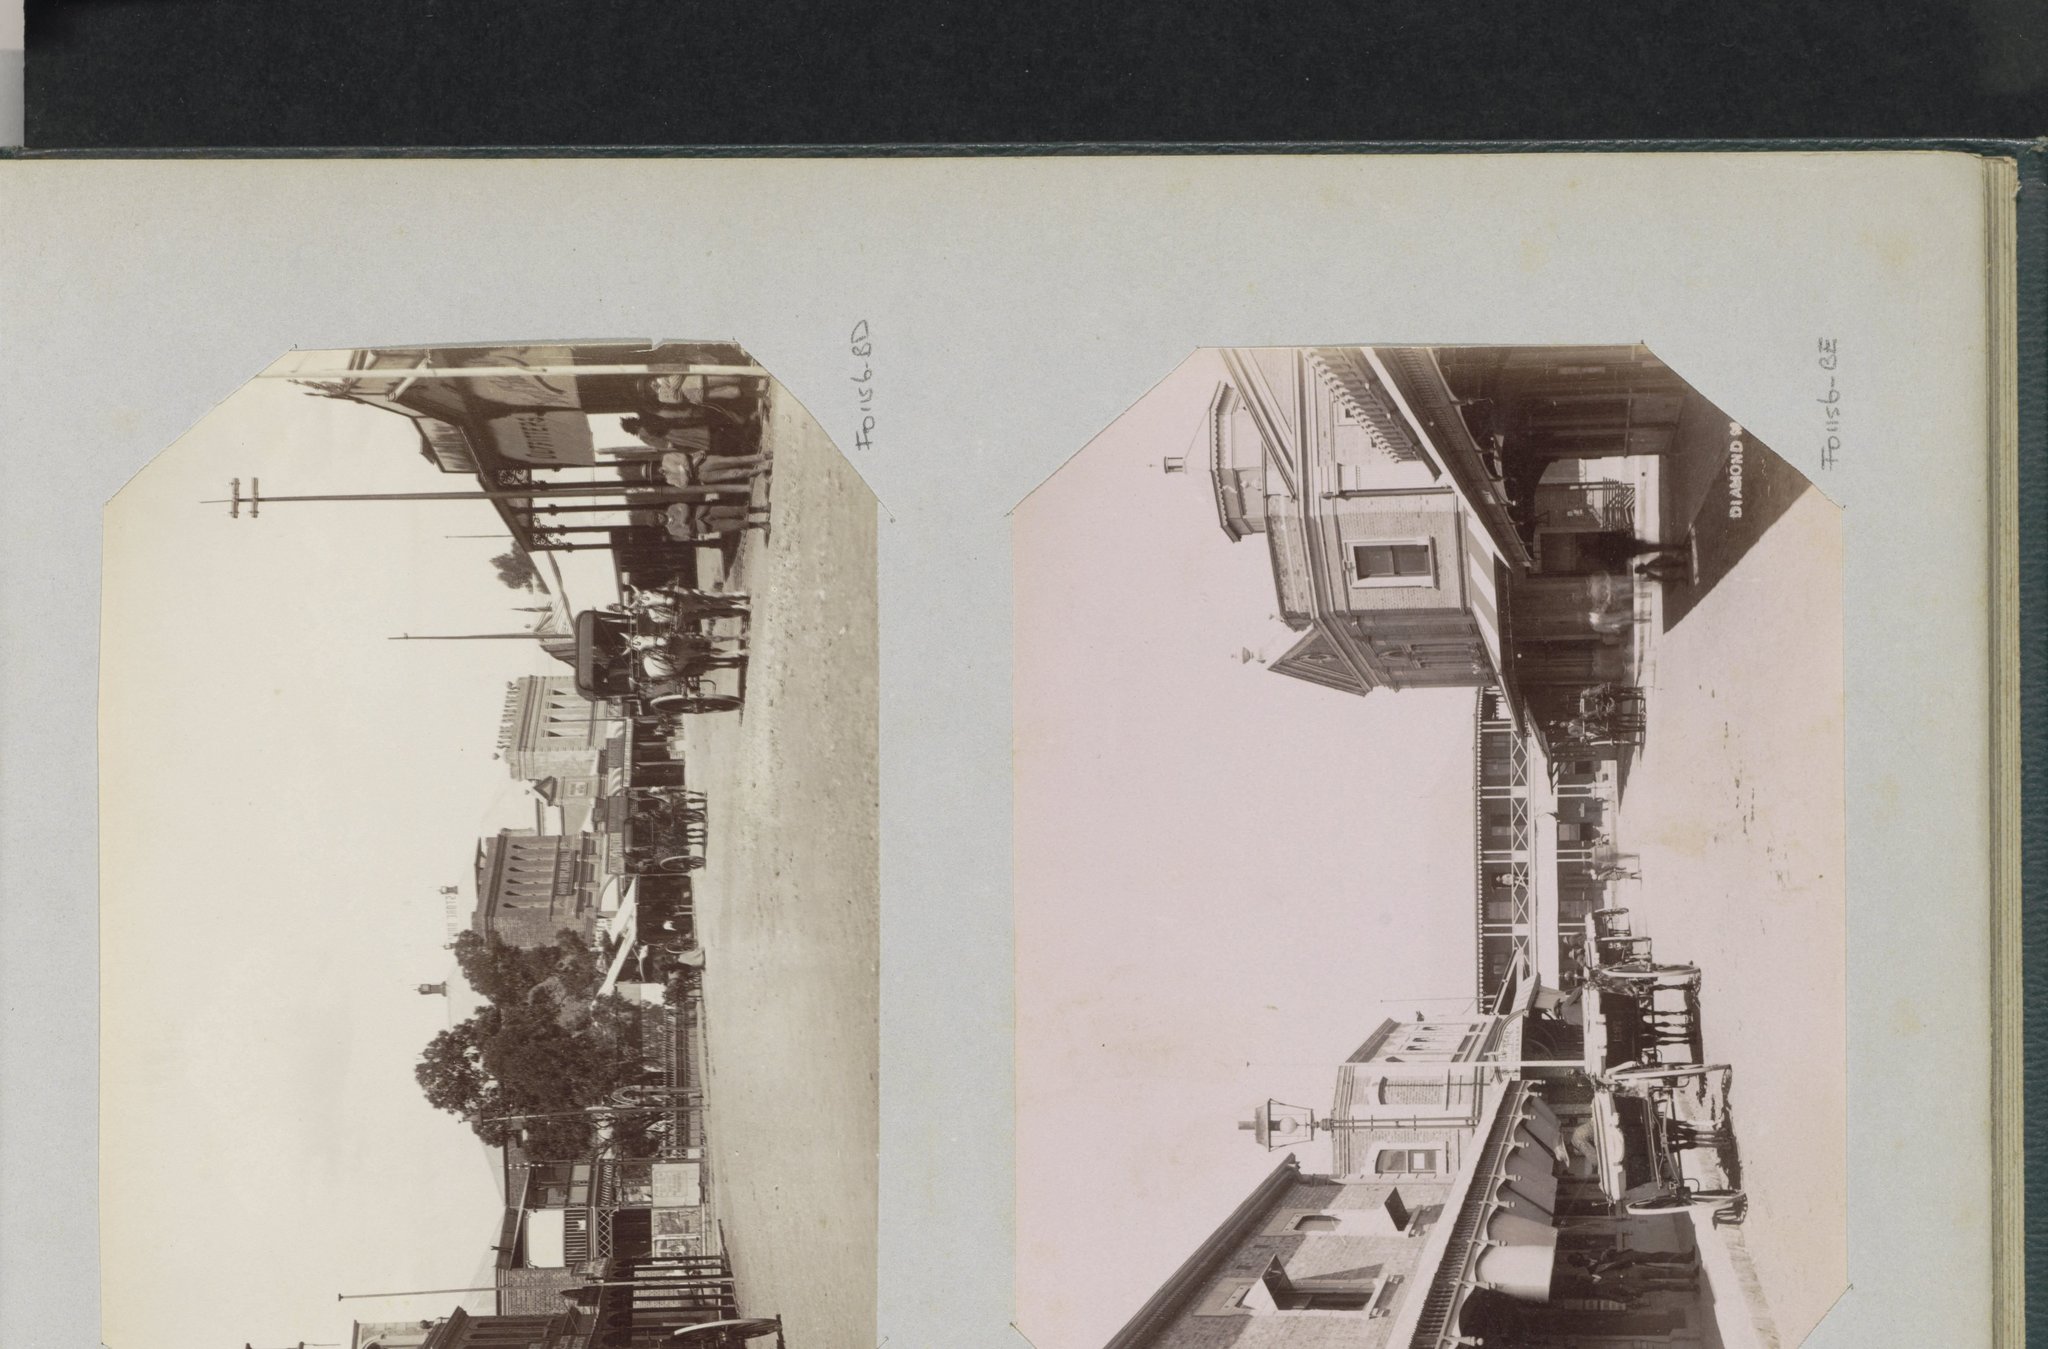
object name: photograph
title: Straatgezicht van Main Street te Kimberley, Zuid-Afrika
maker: Anonymous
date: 1896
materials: photographic support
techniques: albumen print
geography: kimberley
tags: street (+ city(-scape) with figures, staffage)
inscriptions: annotation: ‘Kimberley, Mainstreet, Diamond Market 2/7 april 1896’